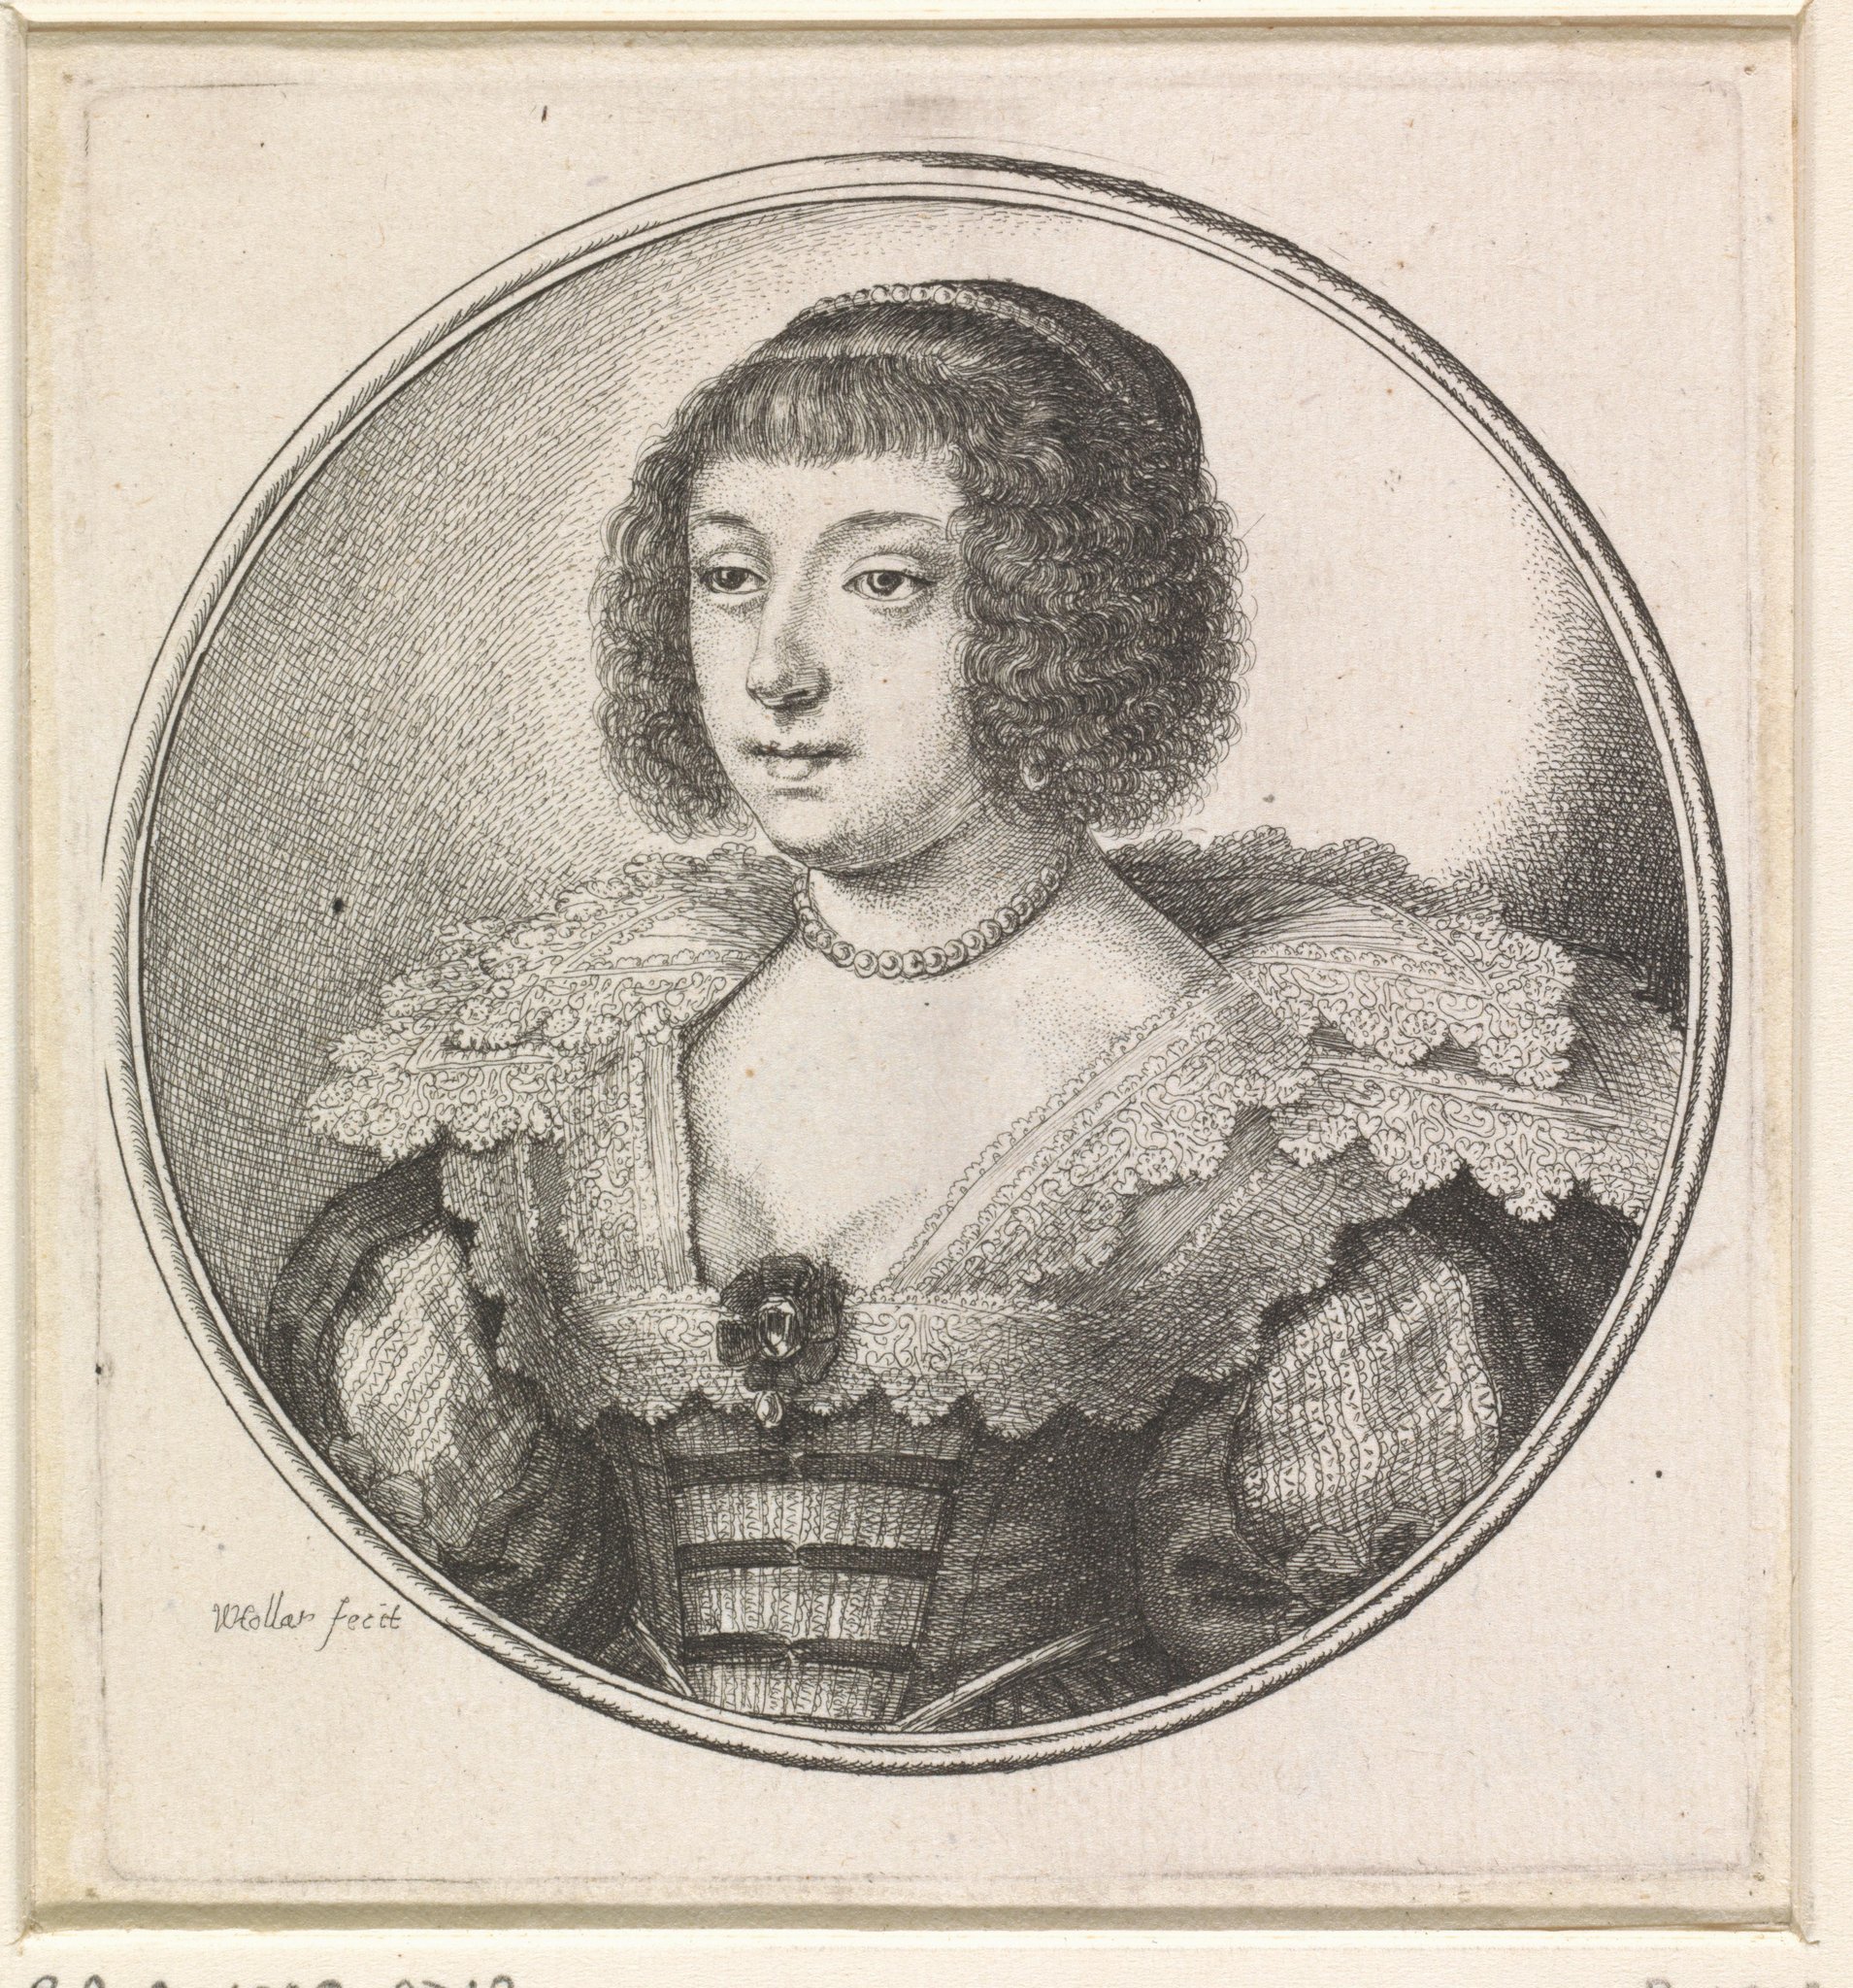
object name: print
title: Vrouw met rijk uitgevoerde kanten kraag en parelketting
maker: wenceslaus hollar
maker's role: draughtsman, print maker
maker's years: 1607-1677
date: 1644-1647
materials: paper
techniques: etching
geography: antwerp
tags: brooch, agraffe, clasp (+ women's clothes), diadem, tiara (+ women's clothes), anonymous historical person portrayed alone - bb - woman, neck-gear: collar (+ women's clothes), neck-gear: collar (+ lace used for clothes), hairdress - aa - ~ women, sleeves (+ women's clothes), necklace (+ women's clothes), clothing for the upper part of the body (with name) (+ women's clothes)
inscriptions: collector's mark: Lugt 654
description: De prent maakt deel uit van een 23-delige serie met verschillende vrouwenbusten in ronde lijsten.